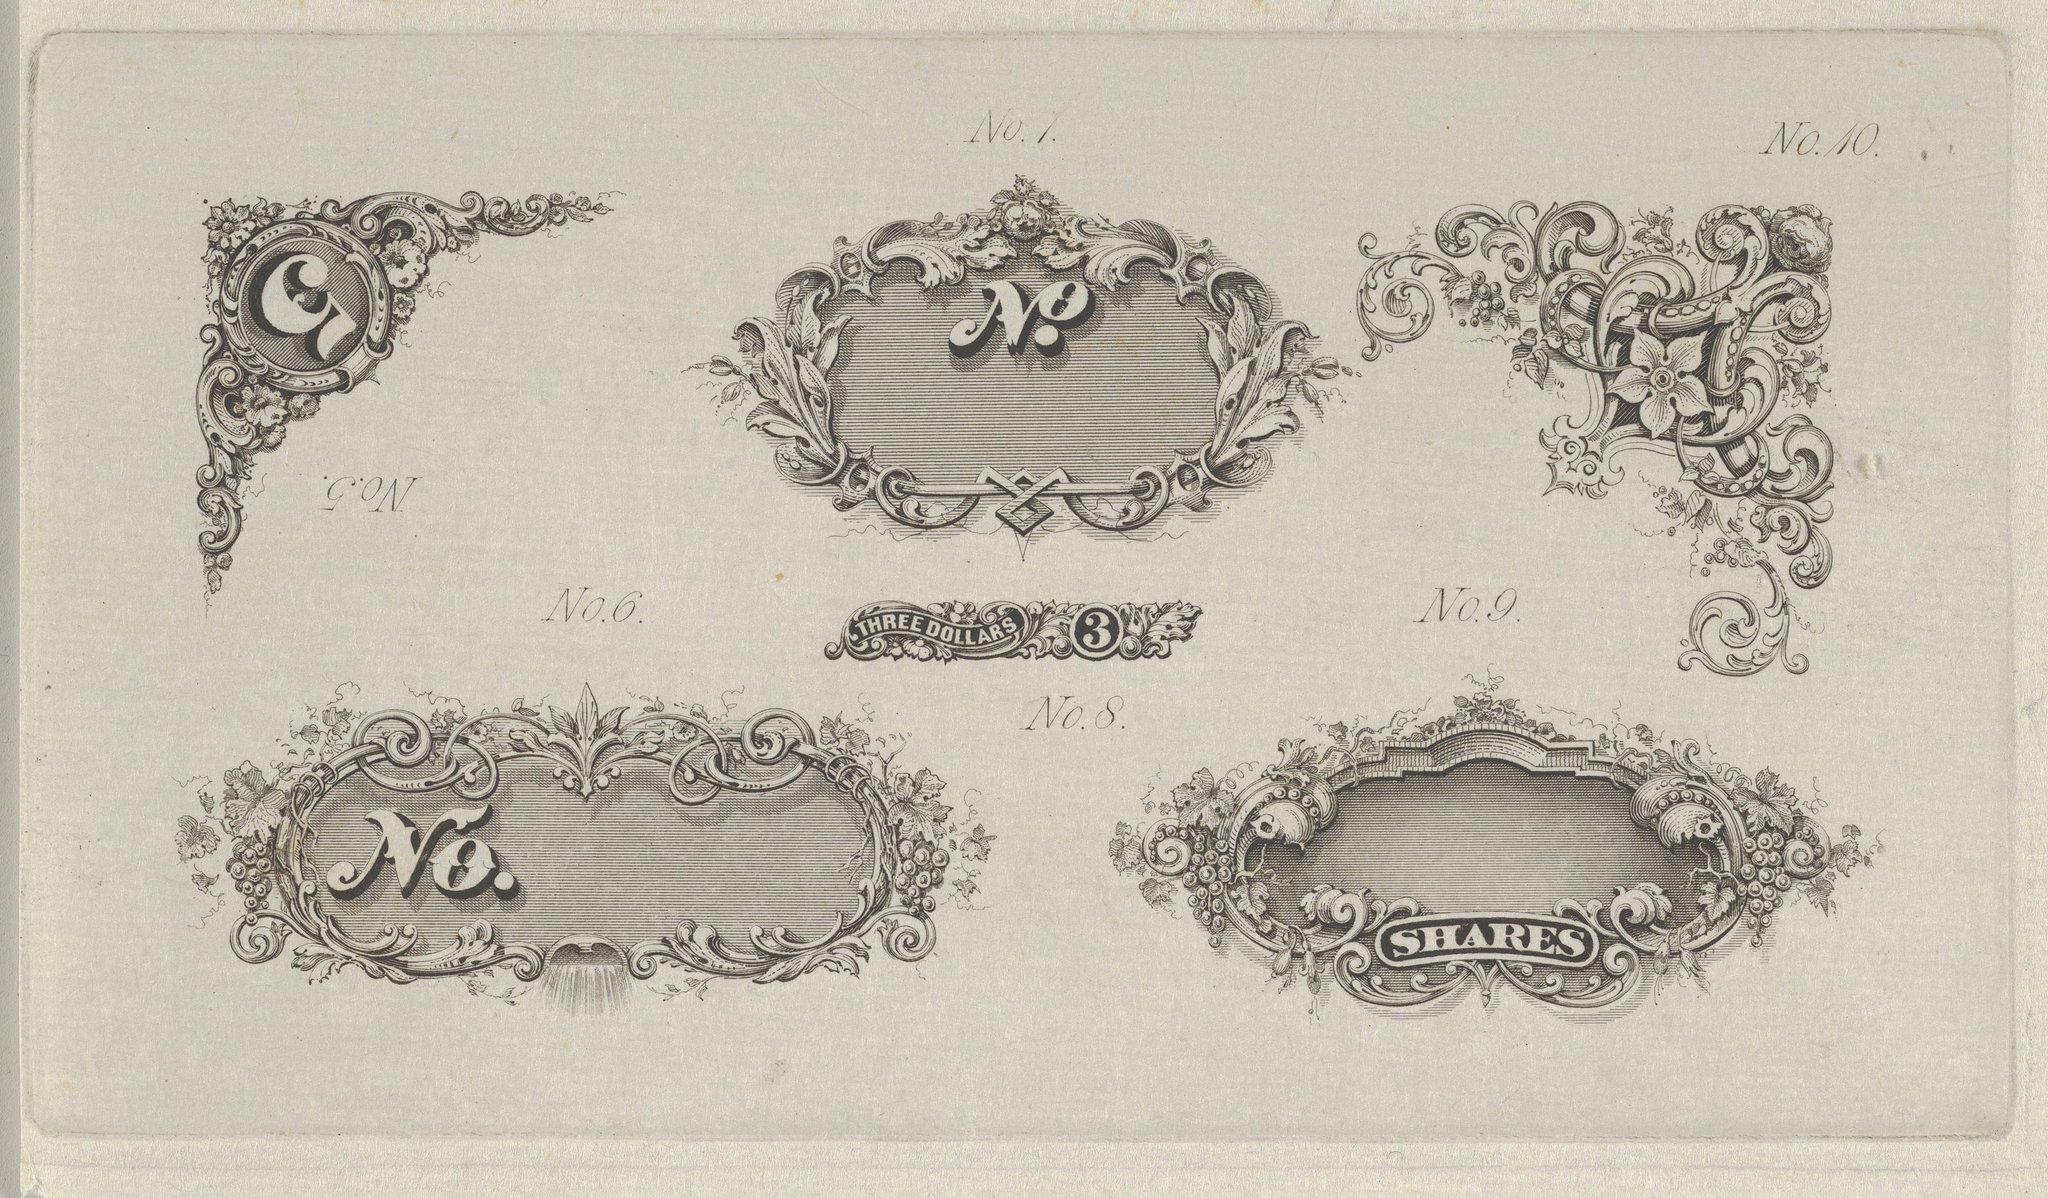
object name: print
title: Banknote motifs: six small lathe work designs for corners, frames and numbers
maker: cyrus durand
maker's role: artist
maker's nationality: american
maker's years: 1787-1868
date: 1824-1842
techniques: engraving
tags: ornament